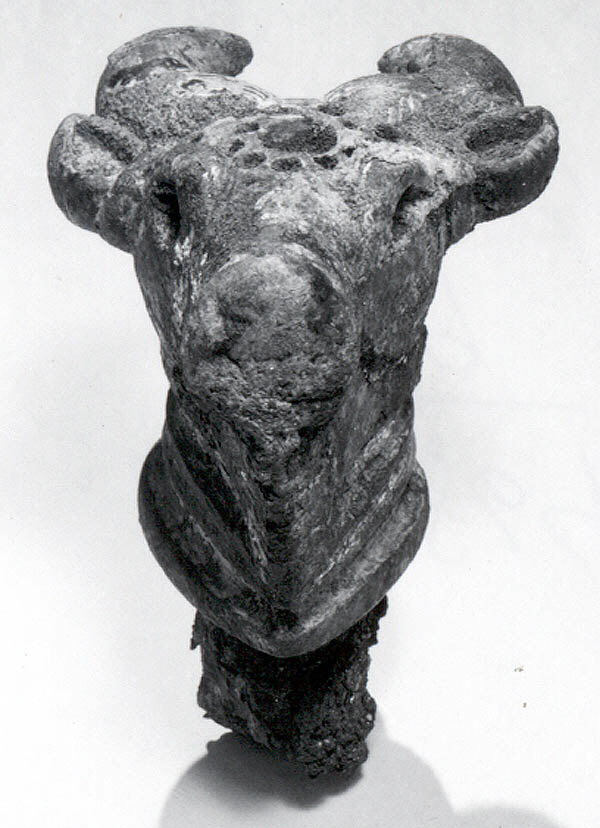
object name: scepter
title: Scepter in the shape of a bull's head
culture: sasanian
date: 201-700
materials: copper alloy, gold, iron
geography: iran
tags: bulls